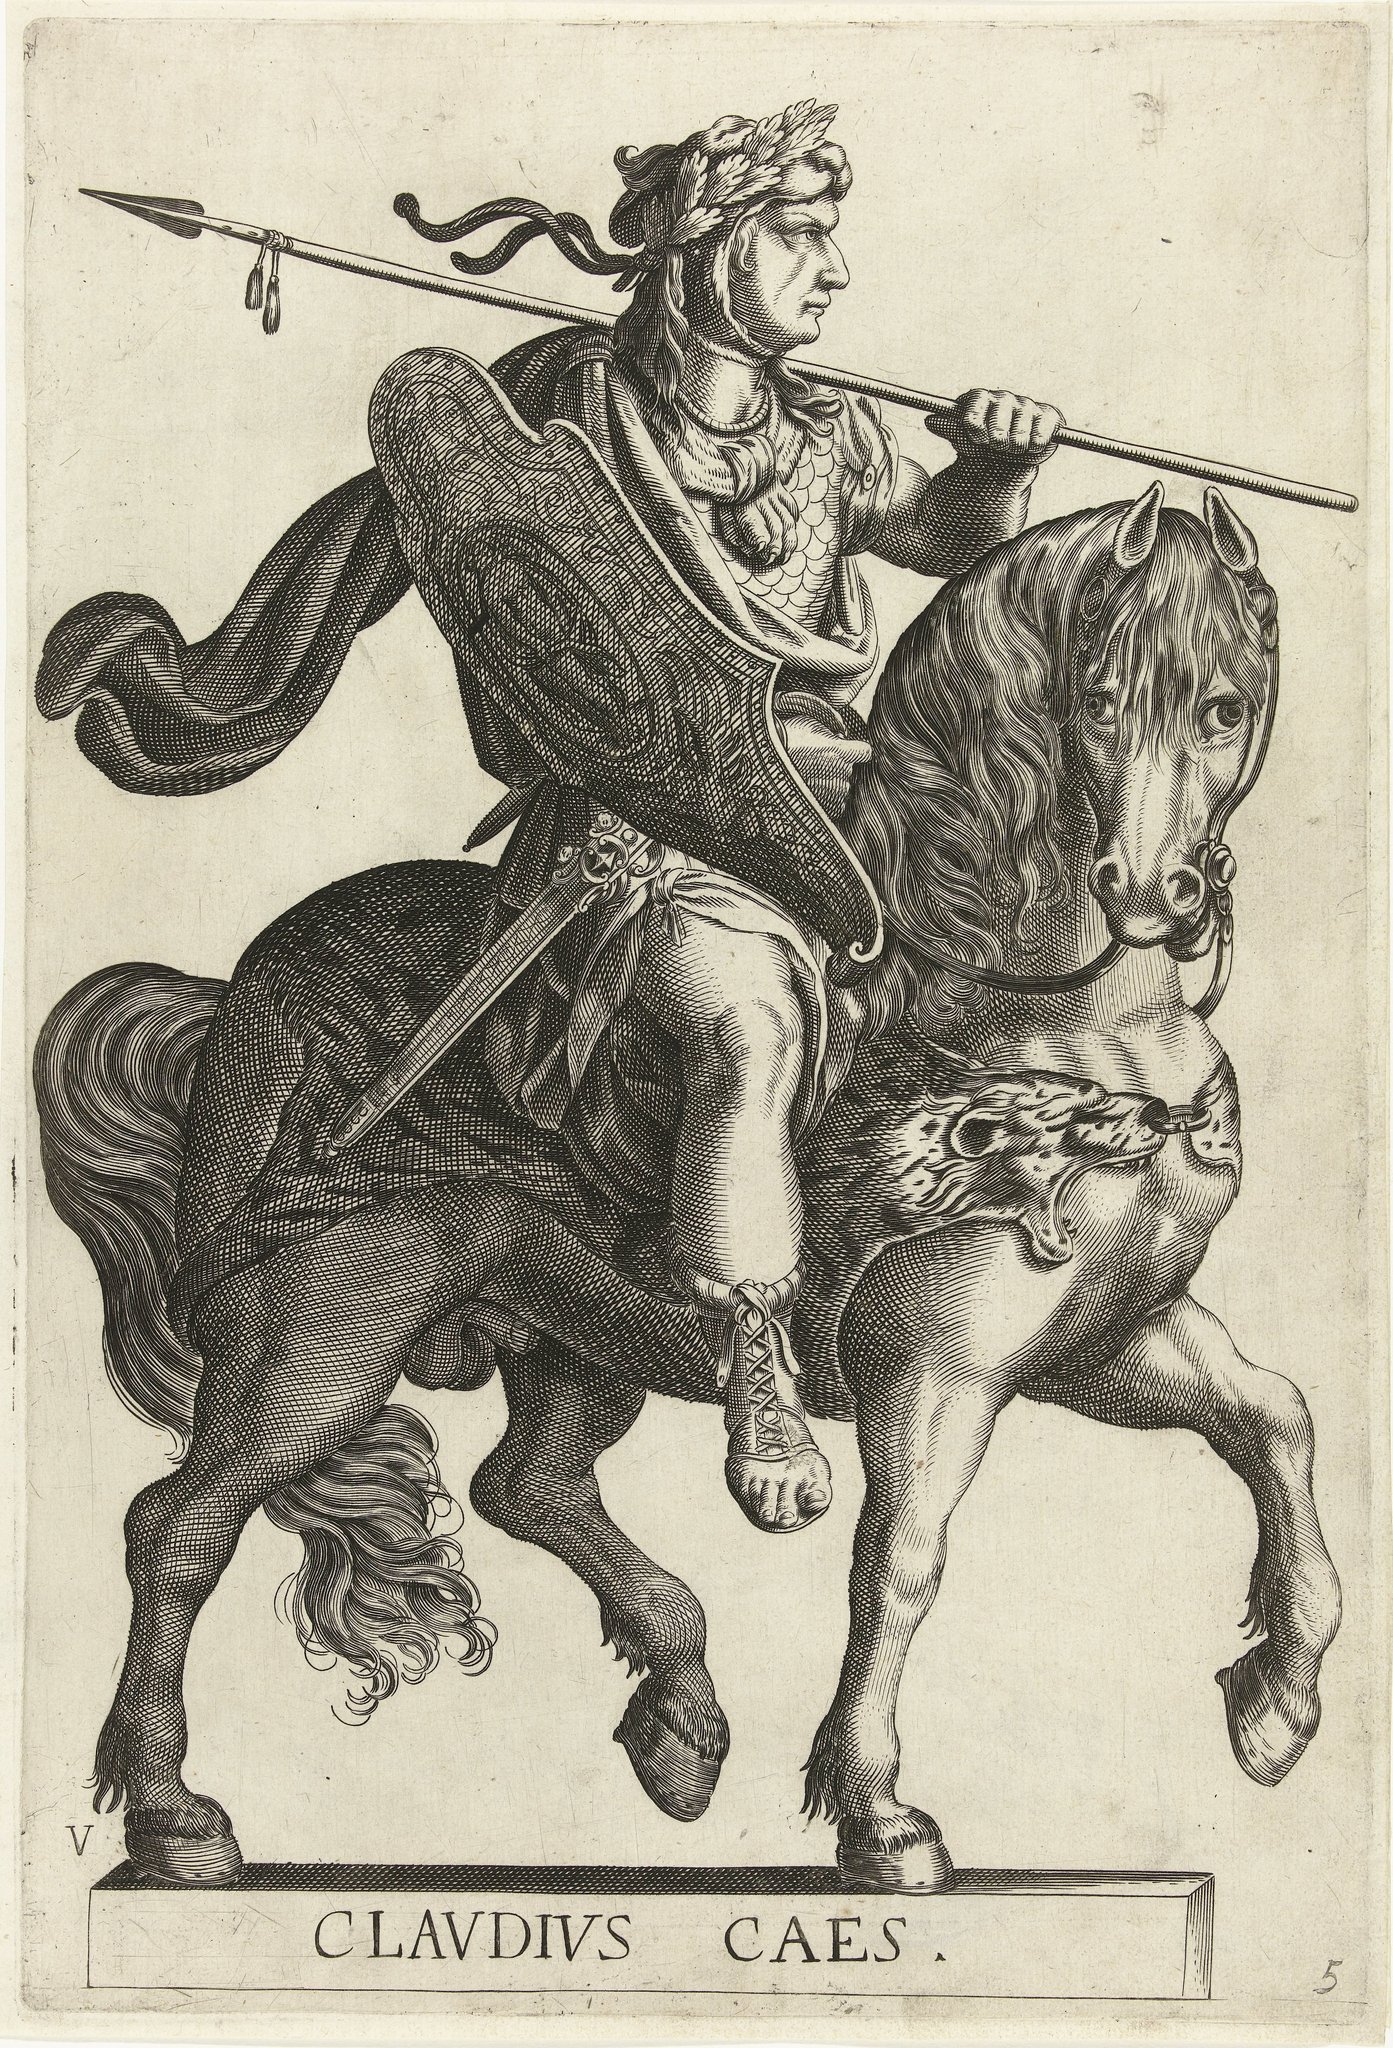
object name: print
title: Ruiterportret van keizer Claudius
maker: laurens eillarts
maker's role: print maker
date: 1616-1620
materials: paper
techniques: engraving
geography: italy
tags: keizer, claudius i (keizer van het romeinse rijk)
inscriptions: collector's mark: Lugt 2228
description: Keizer Claudius te paard, en profil afgebeeld met speer en schild.